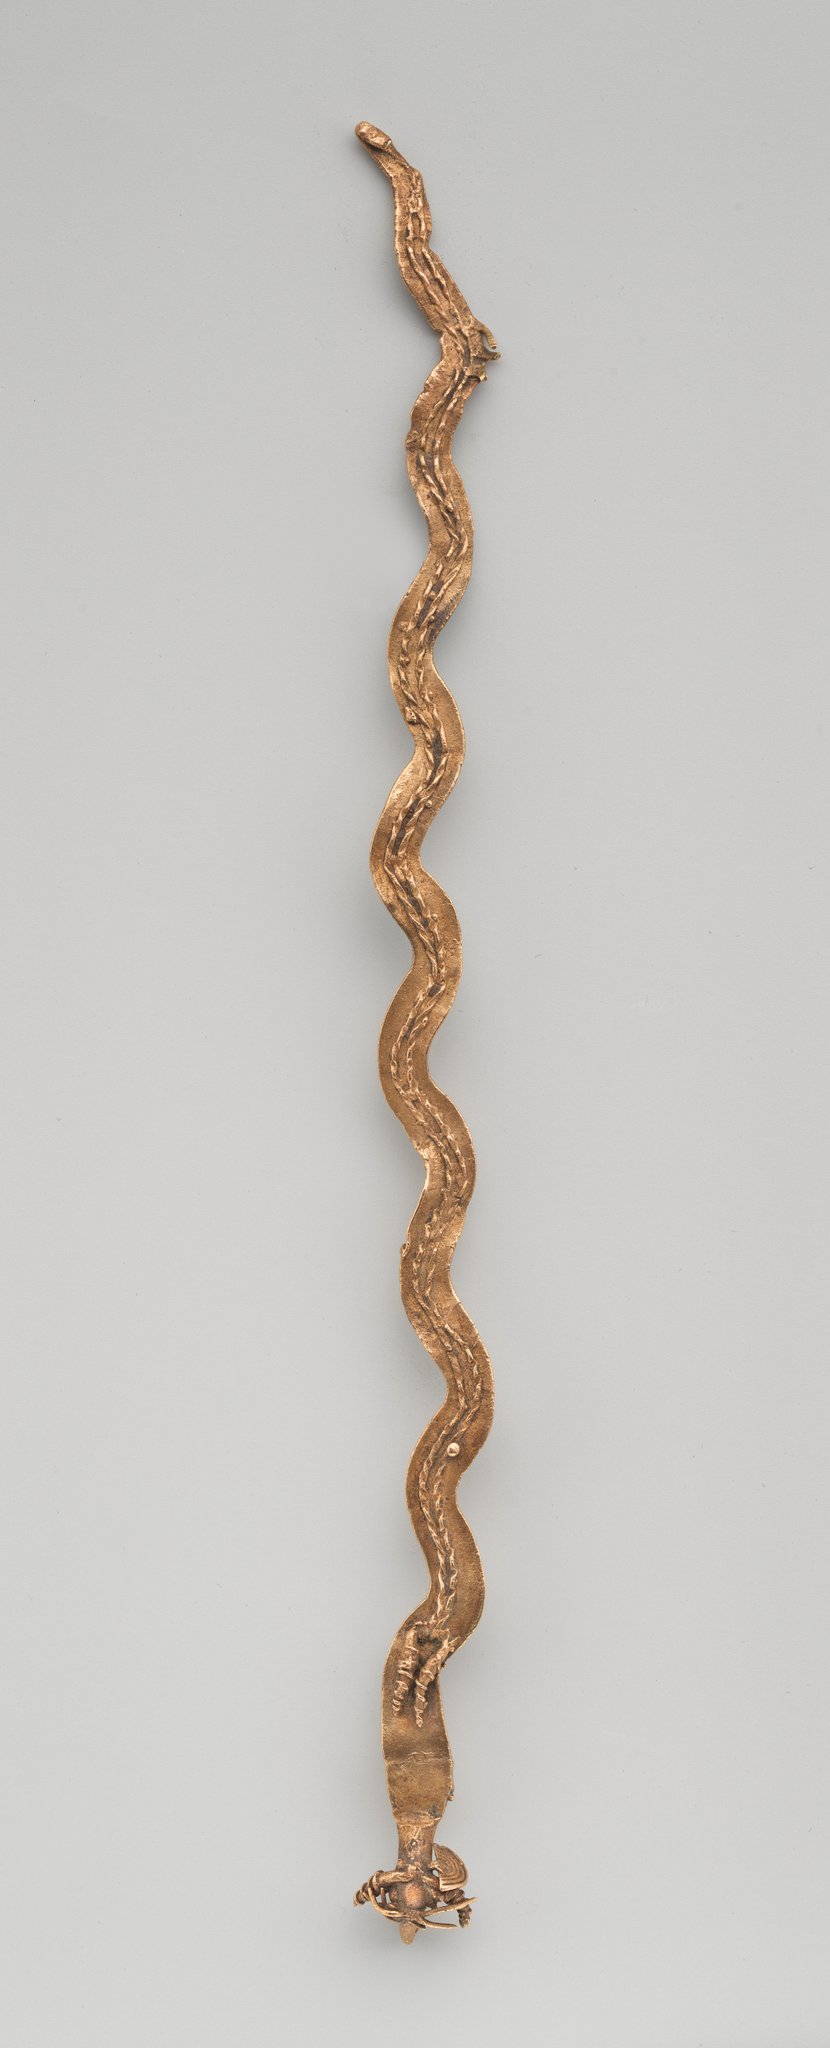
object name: snake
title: Serpent (tunjo)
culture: muisca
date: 901-1600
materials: gold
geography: colombia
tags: serpents